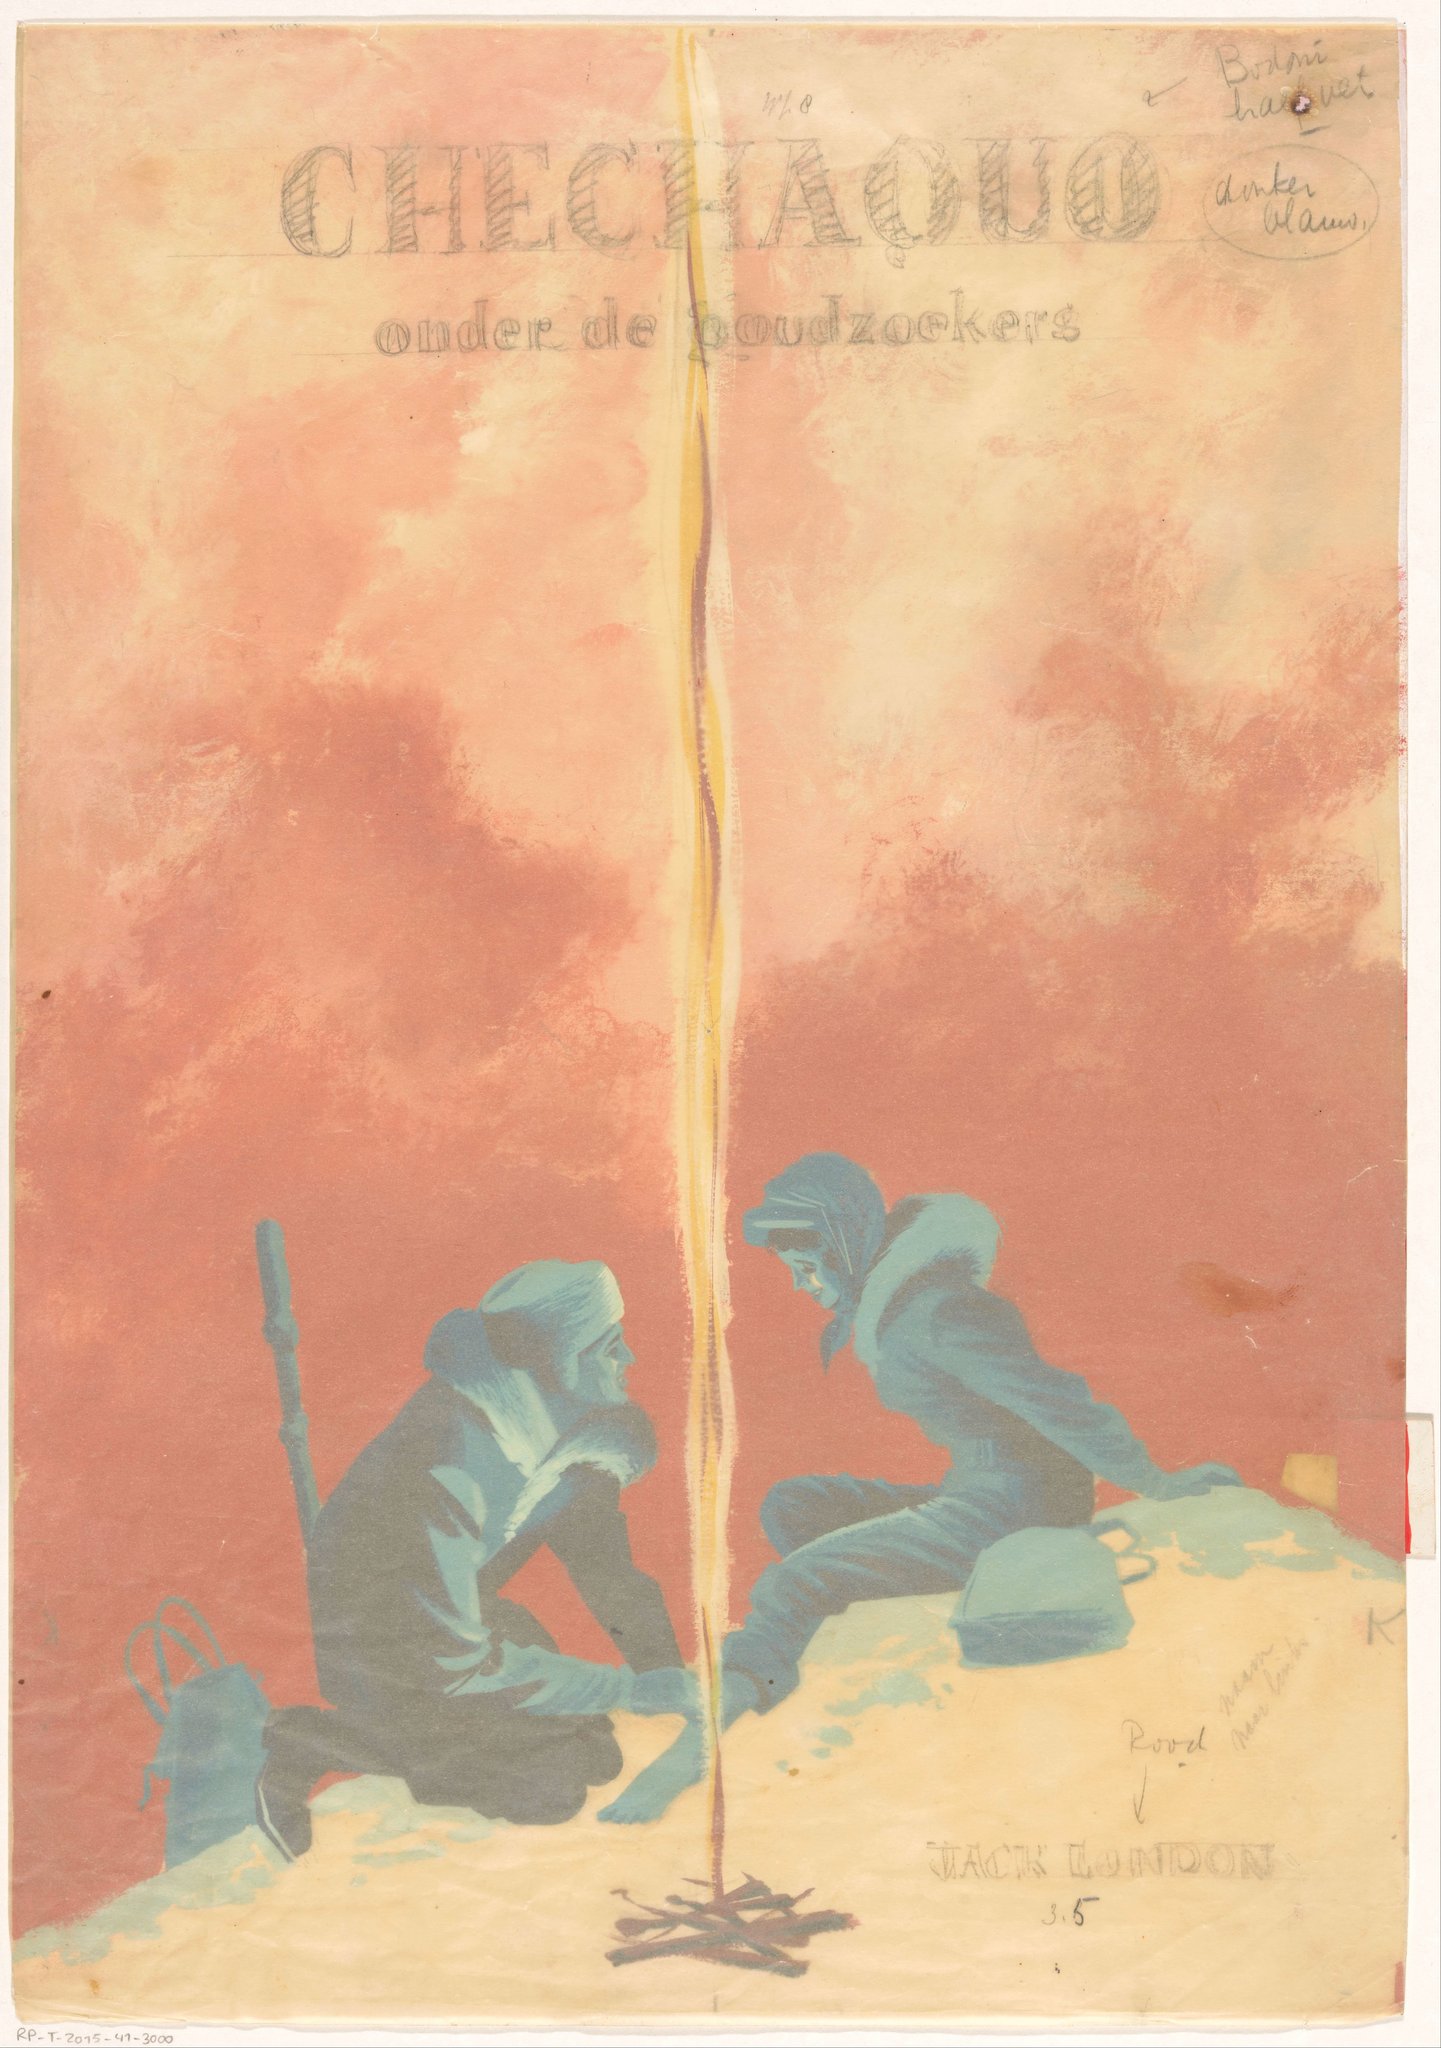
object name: drawing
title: Bandontwerp voor: Jack London, Chechaquo onder de goudzoekers (Chechaquo and old timers), 1958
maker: Anonymous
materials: paint, paper, pencil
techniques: brush, snipping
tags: ankle - aa - female human figure, ice ~ freezing weather, camp-fire; watch-fire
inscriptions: name: ‘teekening/ voor/ reproductie: jac. nuiver/ noorder amstellaan 127 amsterdam/ telefoon 21254 postrekening 81326’, :, collector's mark: Lugt 2228a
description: Een man en vrouw zitten op een besneeuwde helling bij een kampvuur. Ze dragen winterkleding en hebben tassen en een stok bij zich. De man knielt voor de vrouw en pakt haar blote enkel vast.